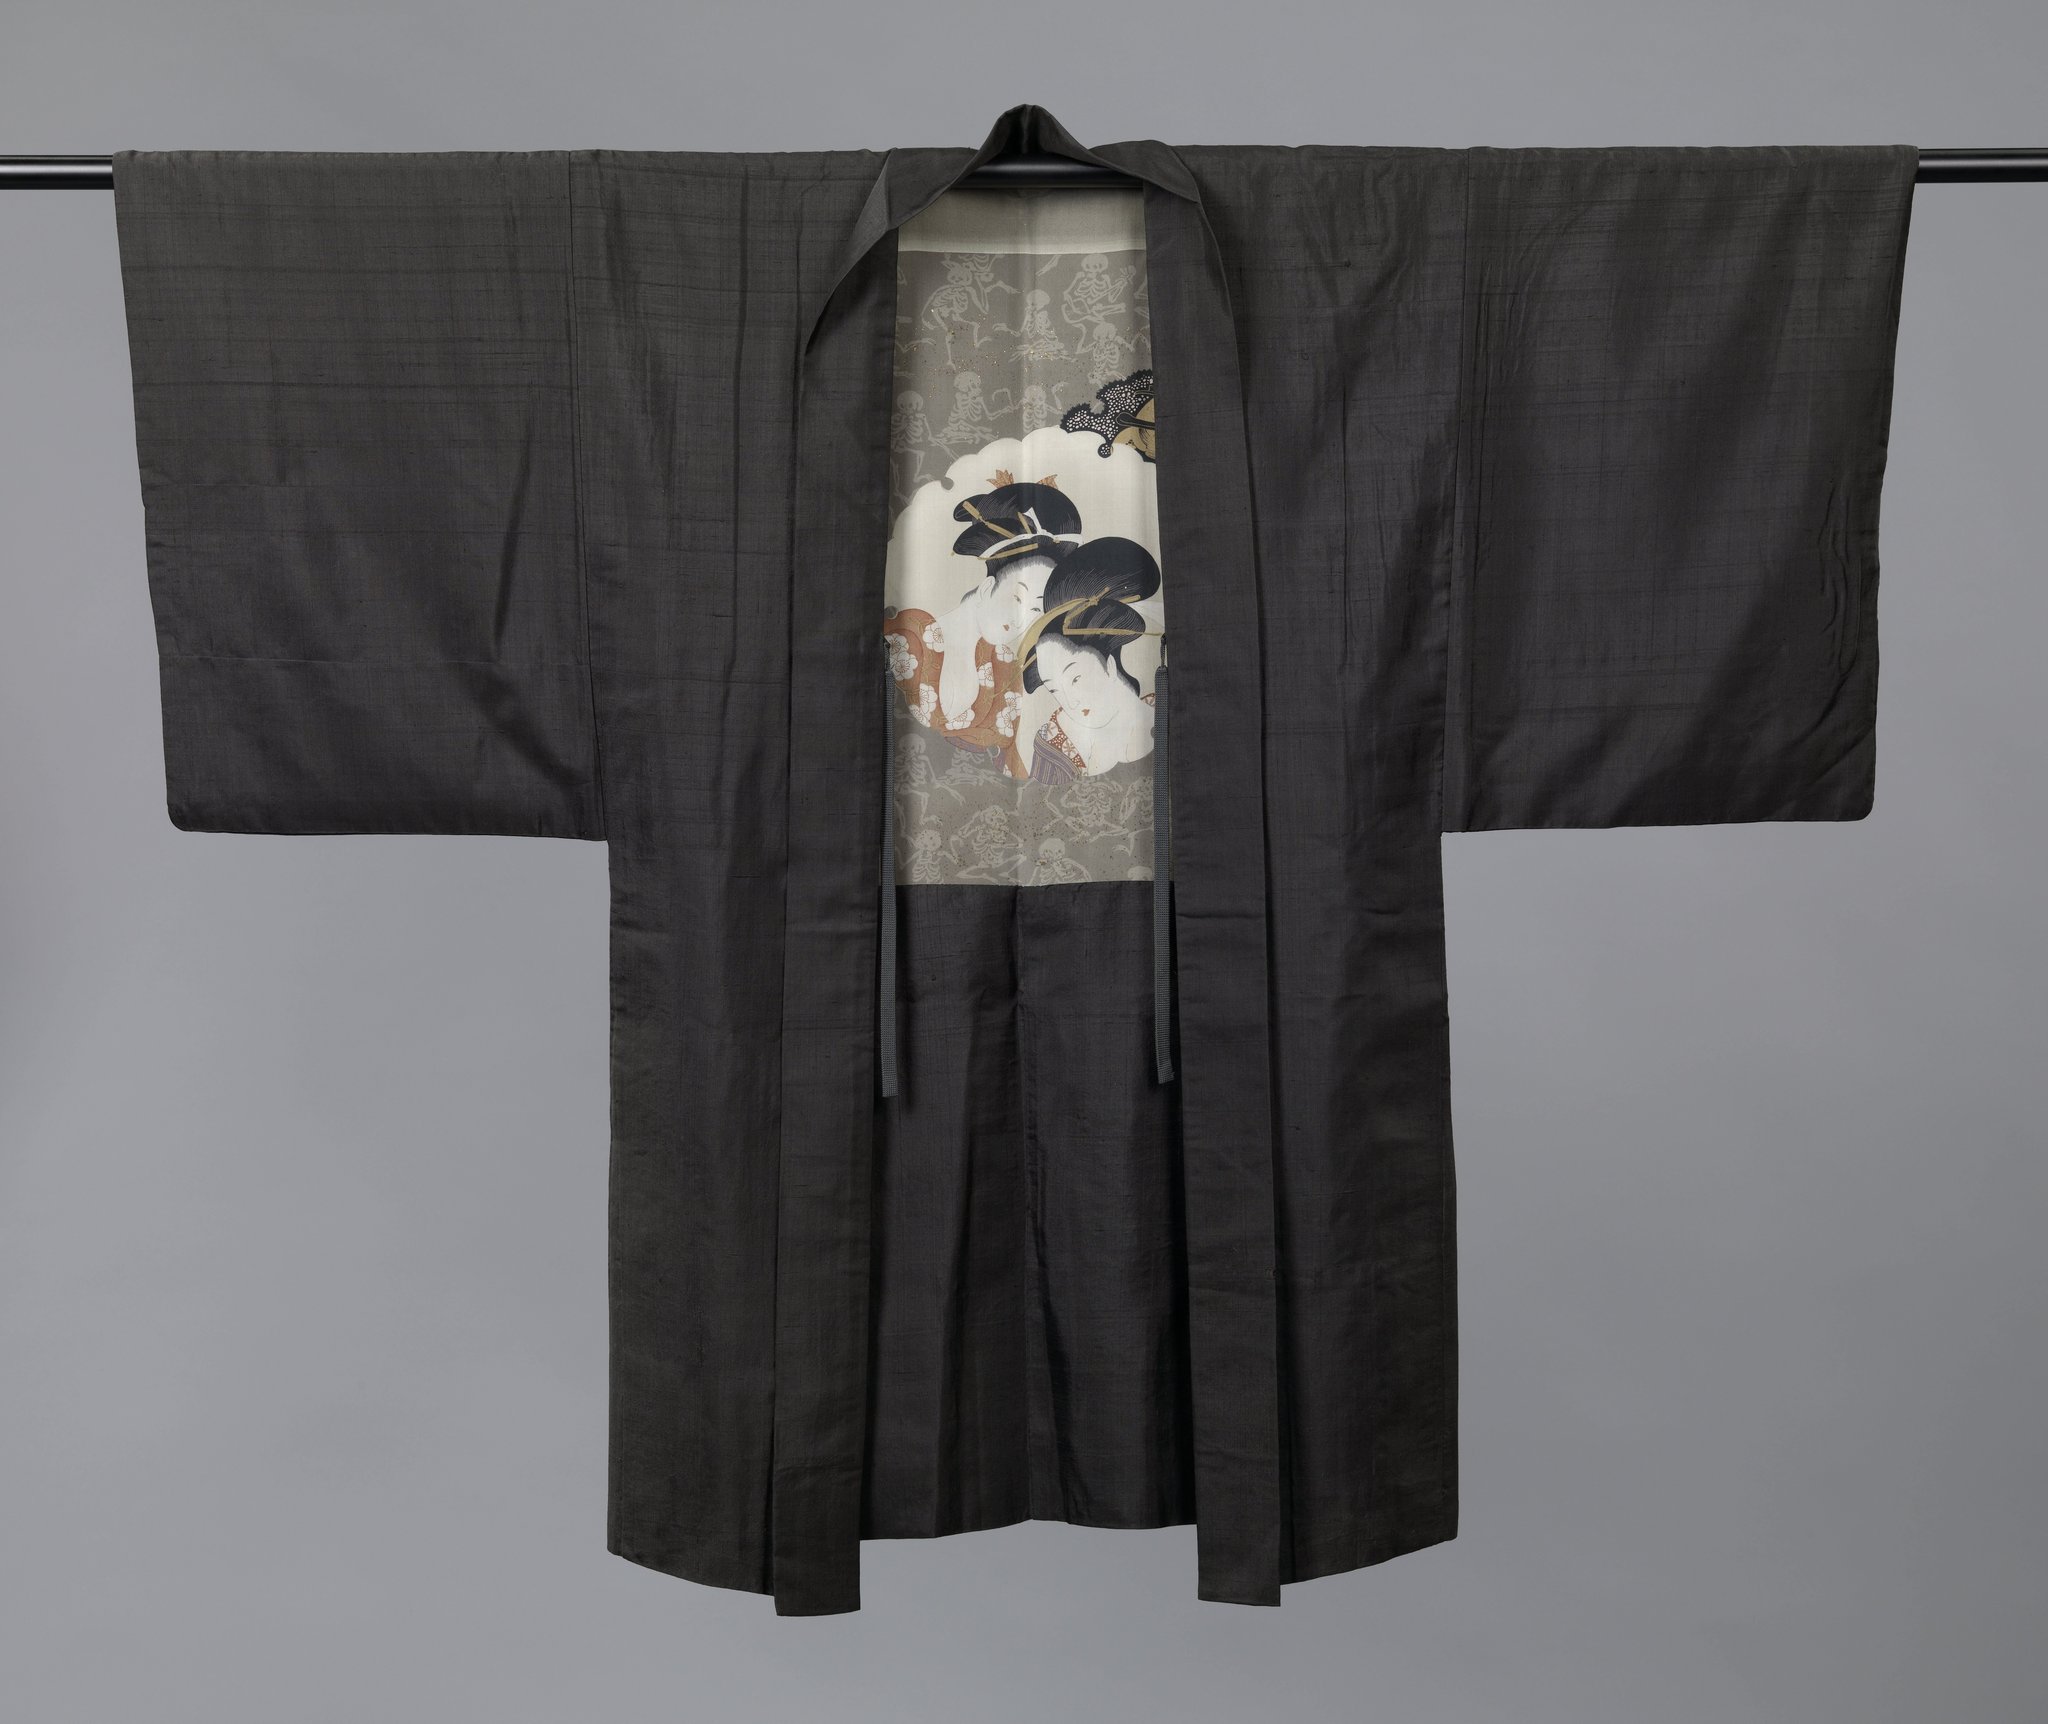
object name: kimono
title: Man’s jacket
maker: Anonymous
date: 1920-1940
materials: silk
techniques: weave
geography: japan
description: This jacket alludes to the fleetingness of life: according to an ancient Japanese concept, man is nothing but a skeleton covered with skin. The skeletons dancing and making music seem to mock the beauty of the two lovely women. They are depicted in a circular snowflake shape, a motif also signifying transience.